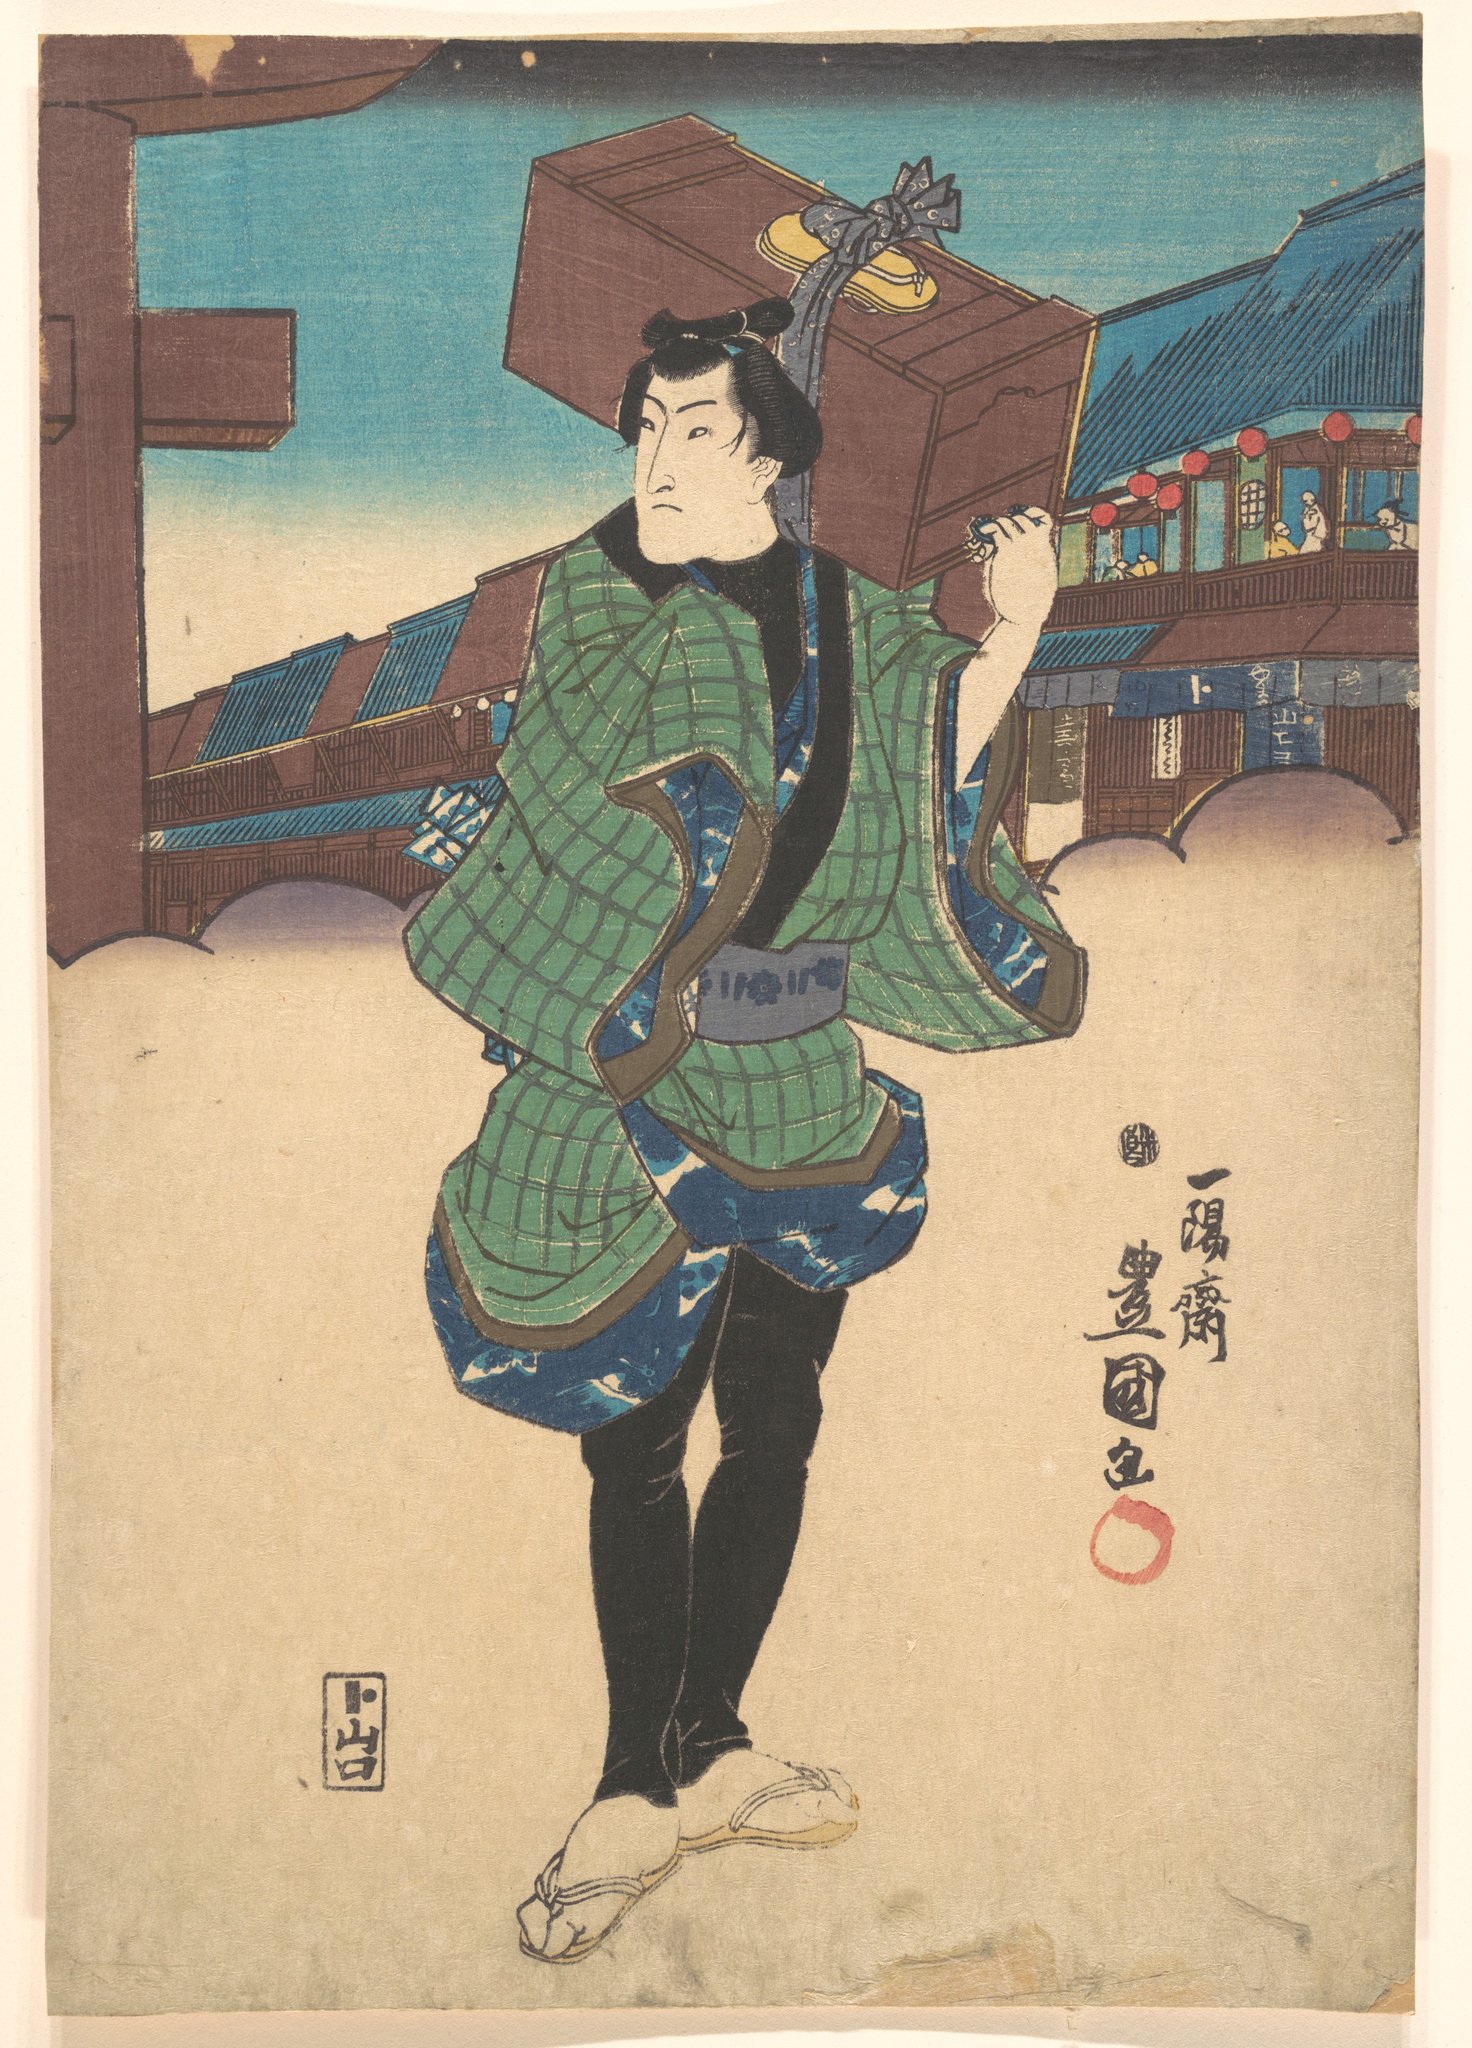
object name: print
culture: japanese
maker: utagawa kunisada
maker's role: artist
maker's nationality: japanese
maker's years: 1786-1864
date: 1786-1854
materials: ink, paper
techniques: woodblock print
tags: men